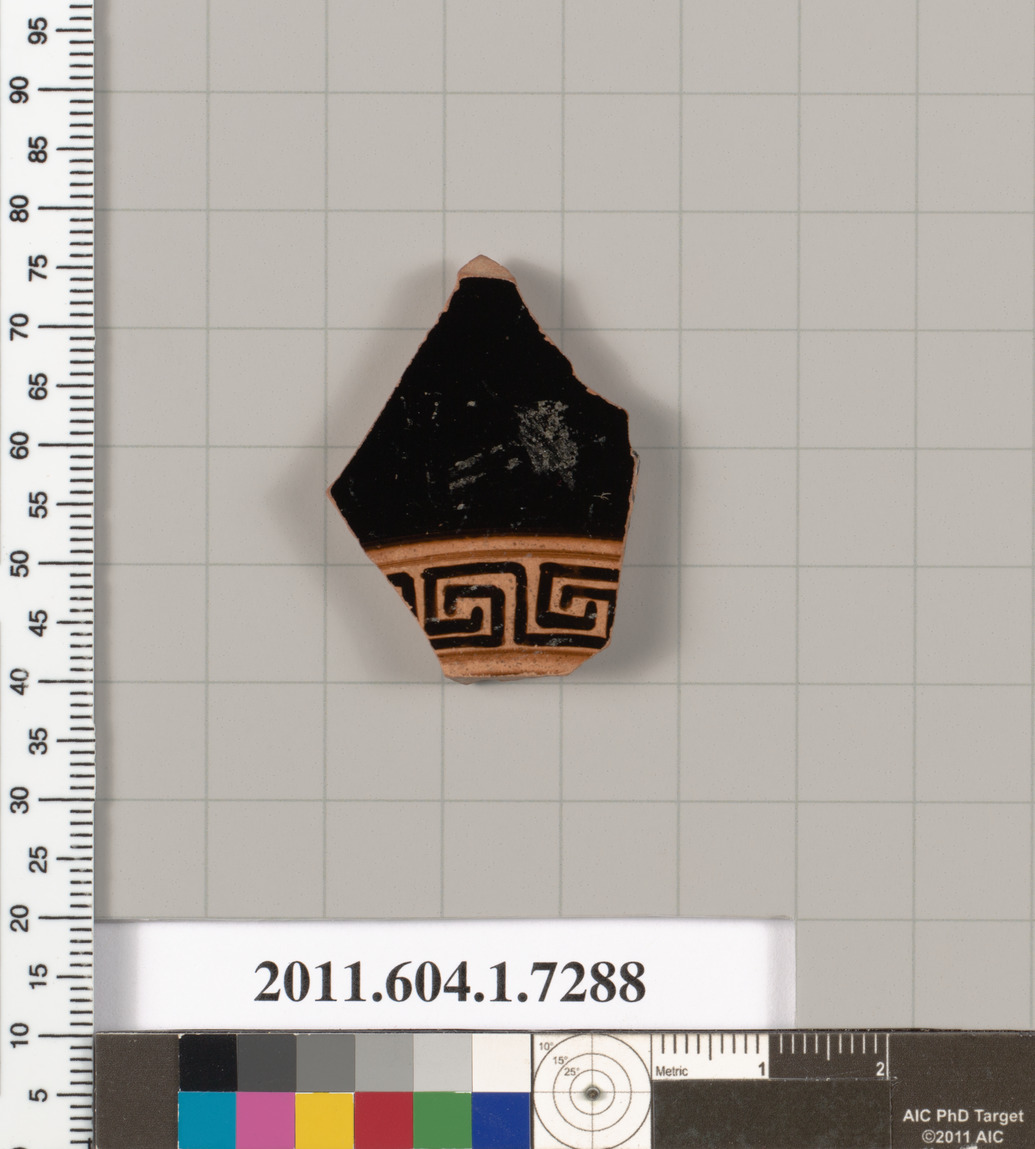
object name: kylix fragment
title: Terracotta fragment of a kylix (drinking cup)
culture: greek, attic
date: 500-480 BCE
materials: terracotta